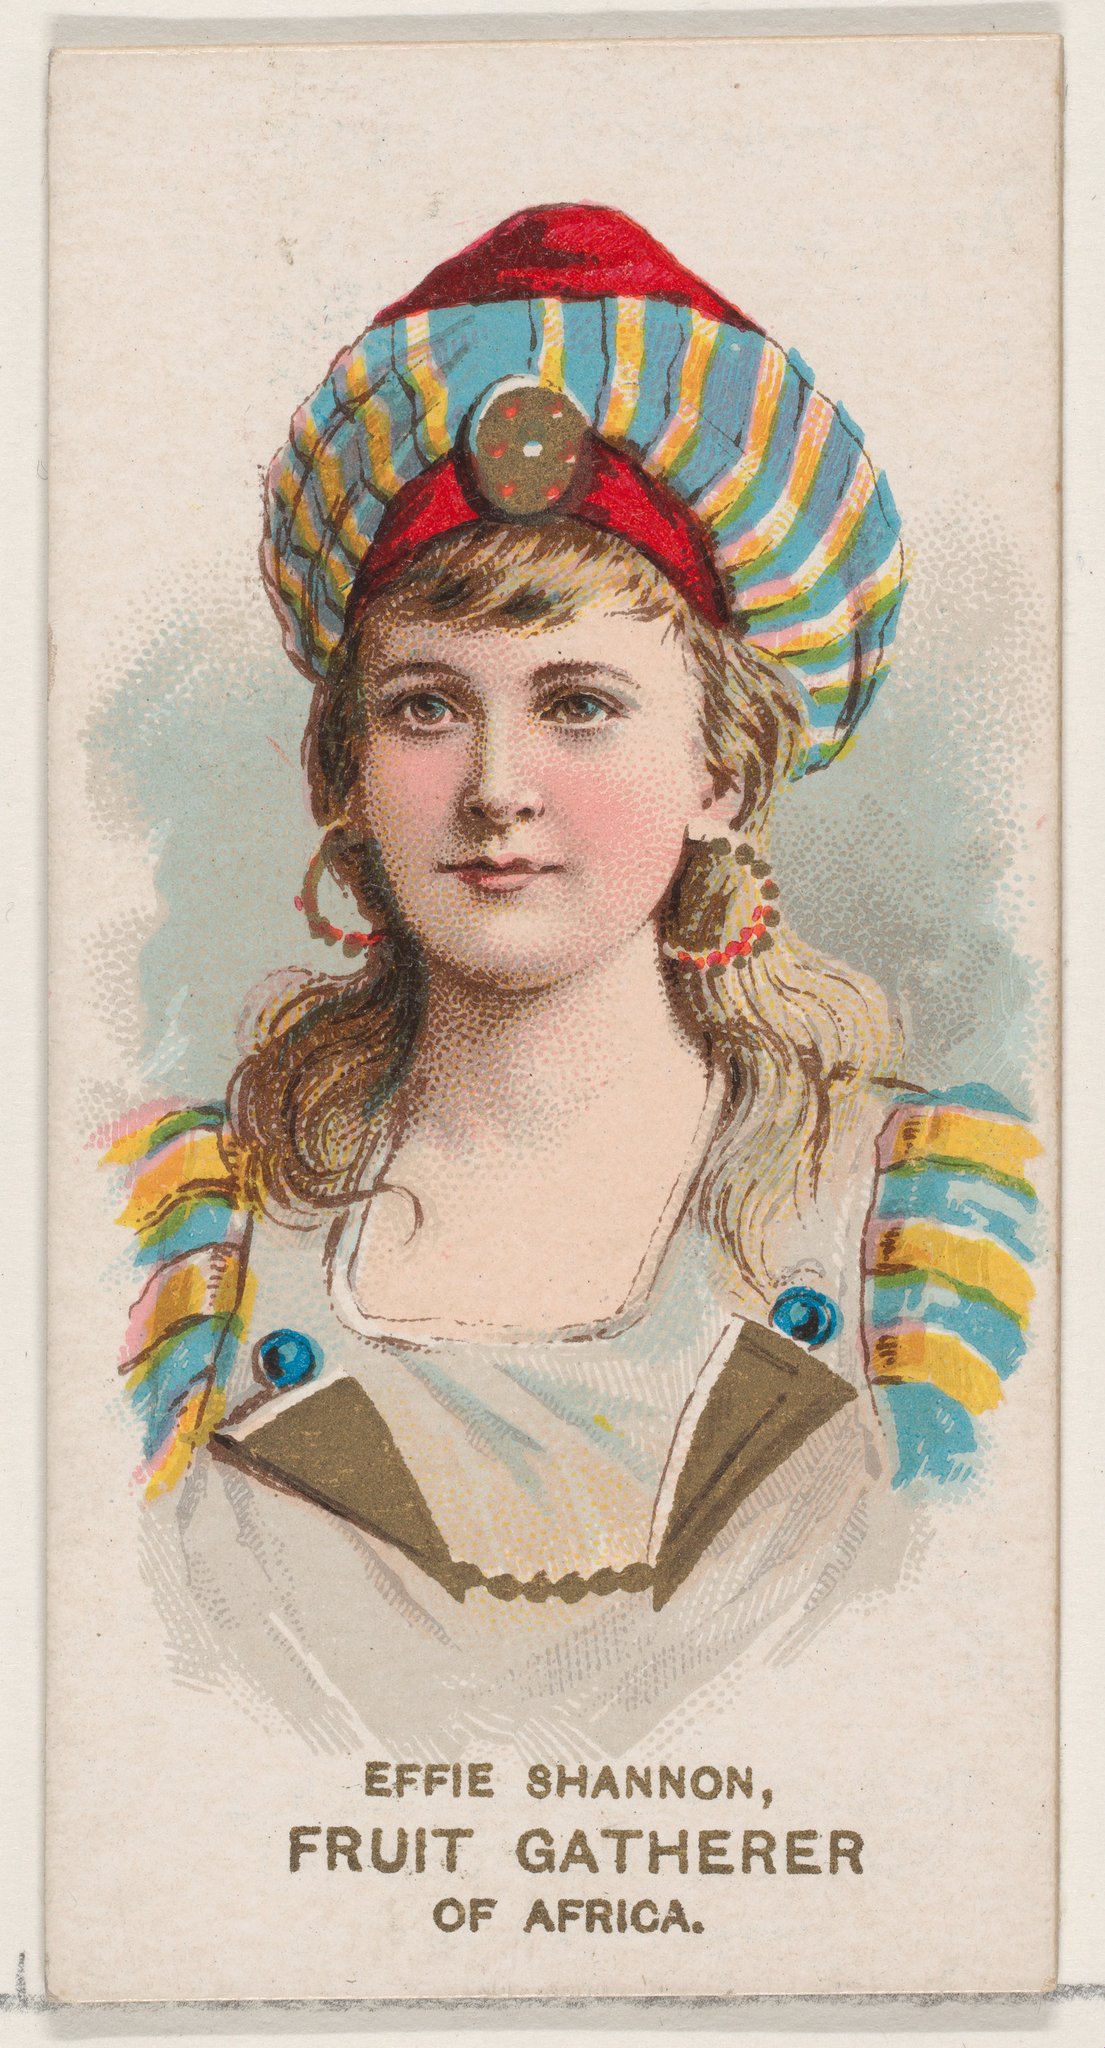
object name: print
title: Effie Shannon Dressed as Fruit Gatherer of Africa, from the set Actors and Actresses, Second Series (N71) for Duke brand cigarettes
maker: w. duke, sons & co.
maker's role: publisher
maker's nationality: american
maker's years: 1870-1920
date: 1888-1890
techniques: color lithograph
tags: women,actresses